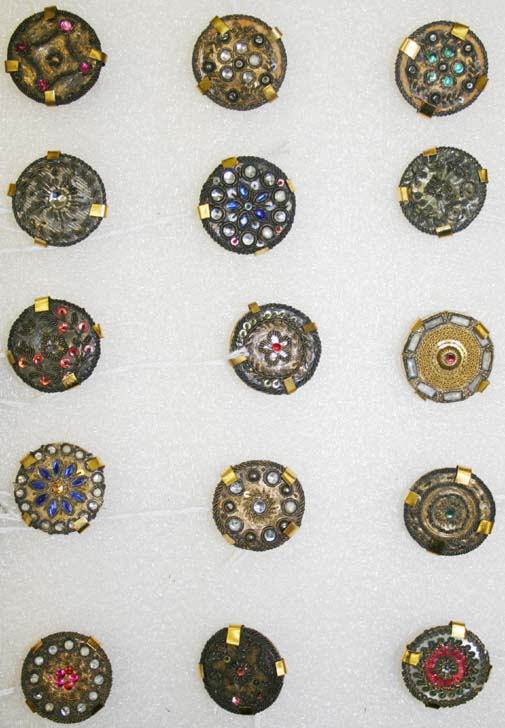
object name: button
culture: french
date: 1775